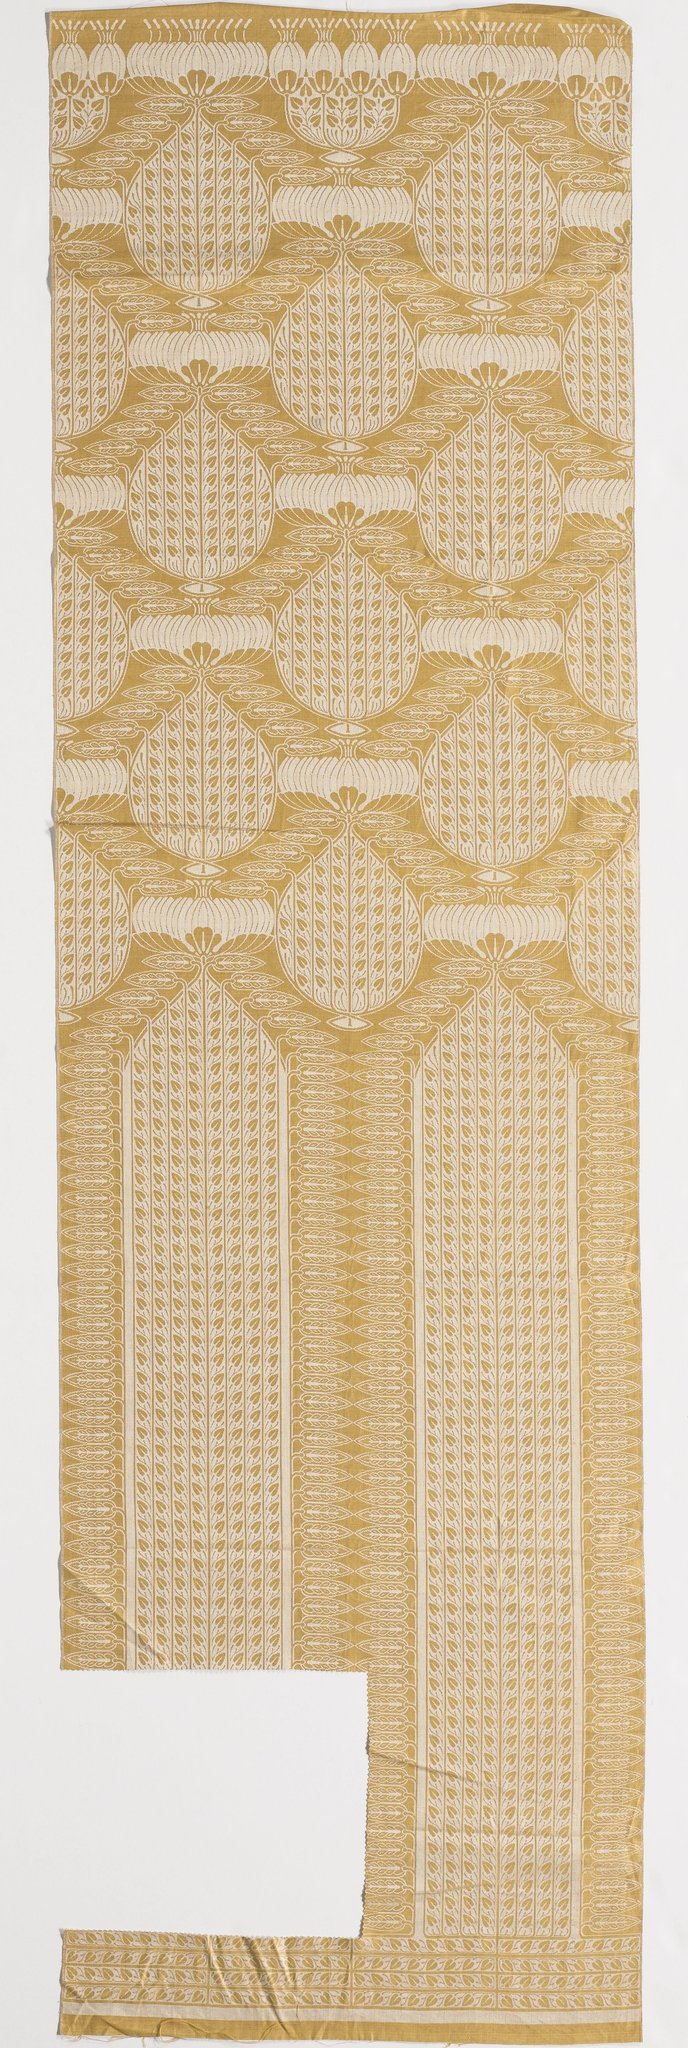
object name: upholstered wall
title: Wandbespanning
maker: chris lebeau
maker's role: draughtsman, print maker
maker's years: 1878-1945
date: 1911-1915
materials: linen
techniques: damask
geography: eindhoven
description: Goudgele damasten wandbespanning met een dessin van waterlelies (?).